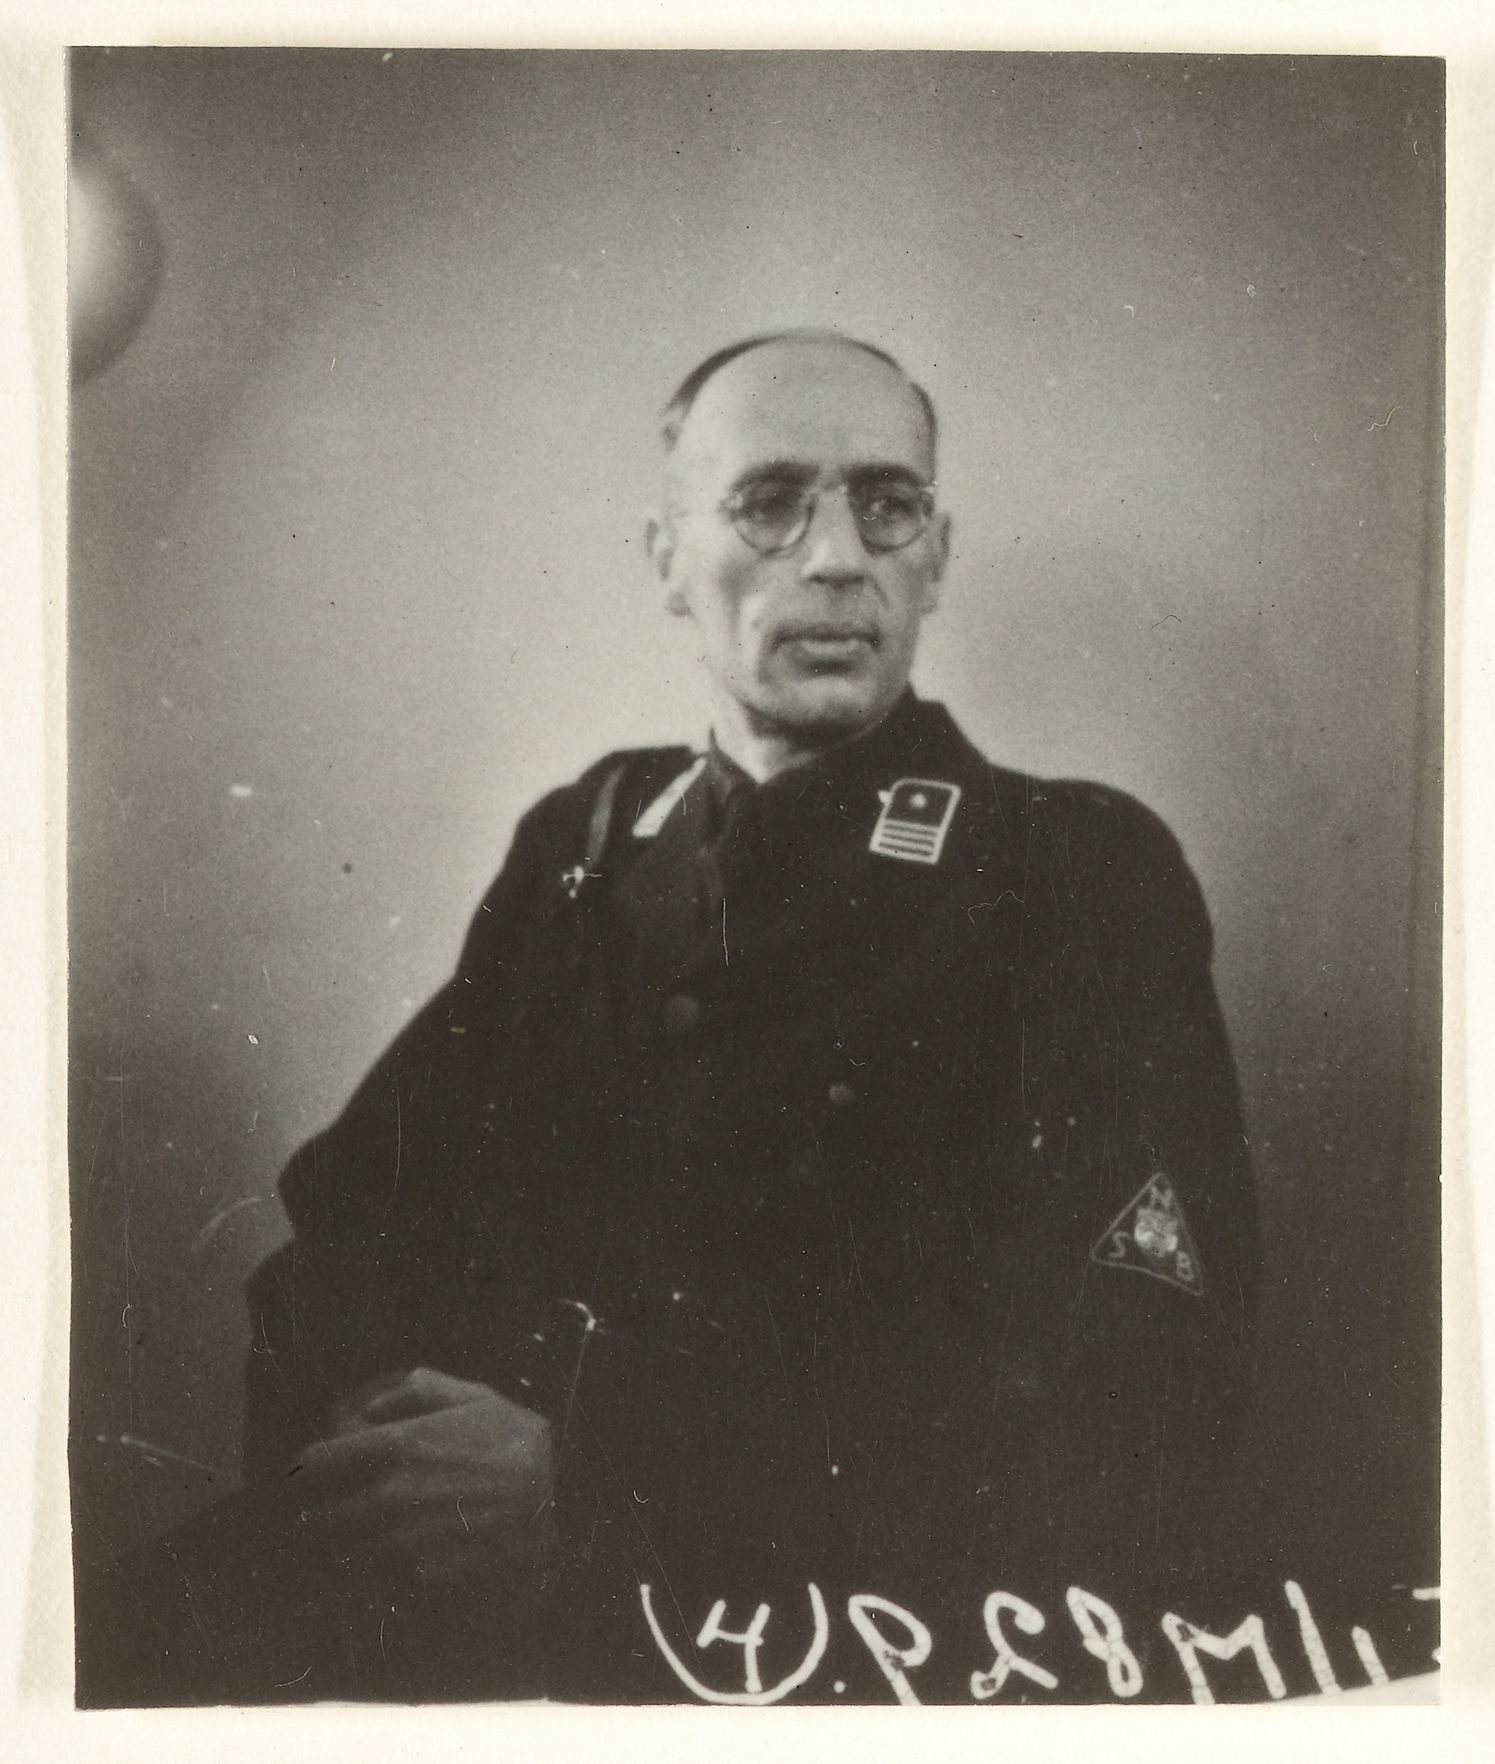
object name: photograph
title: Portret van een lid van de NSB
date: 1940-1944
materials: photographic support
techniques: gelatin silver print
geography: netherlands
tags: anonymous historical person portrayed, netherlands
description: Portret van een lid van de NSB. Op zijn kraag een distinctief wat aangeeft dat hij de functie bekleed van Districtsbeheerder een district besloeg meestal een provincie. Op zijn rechtermouw het driehoekige NSB embleem. Hij draagt een bril en zit met de handen in elkaar. Blootshoofd.